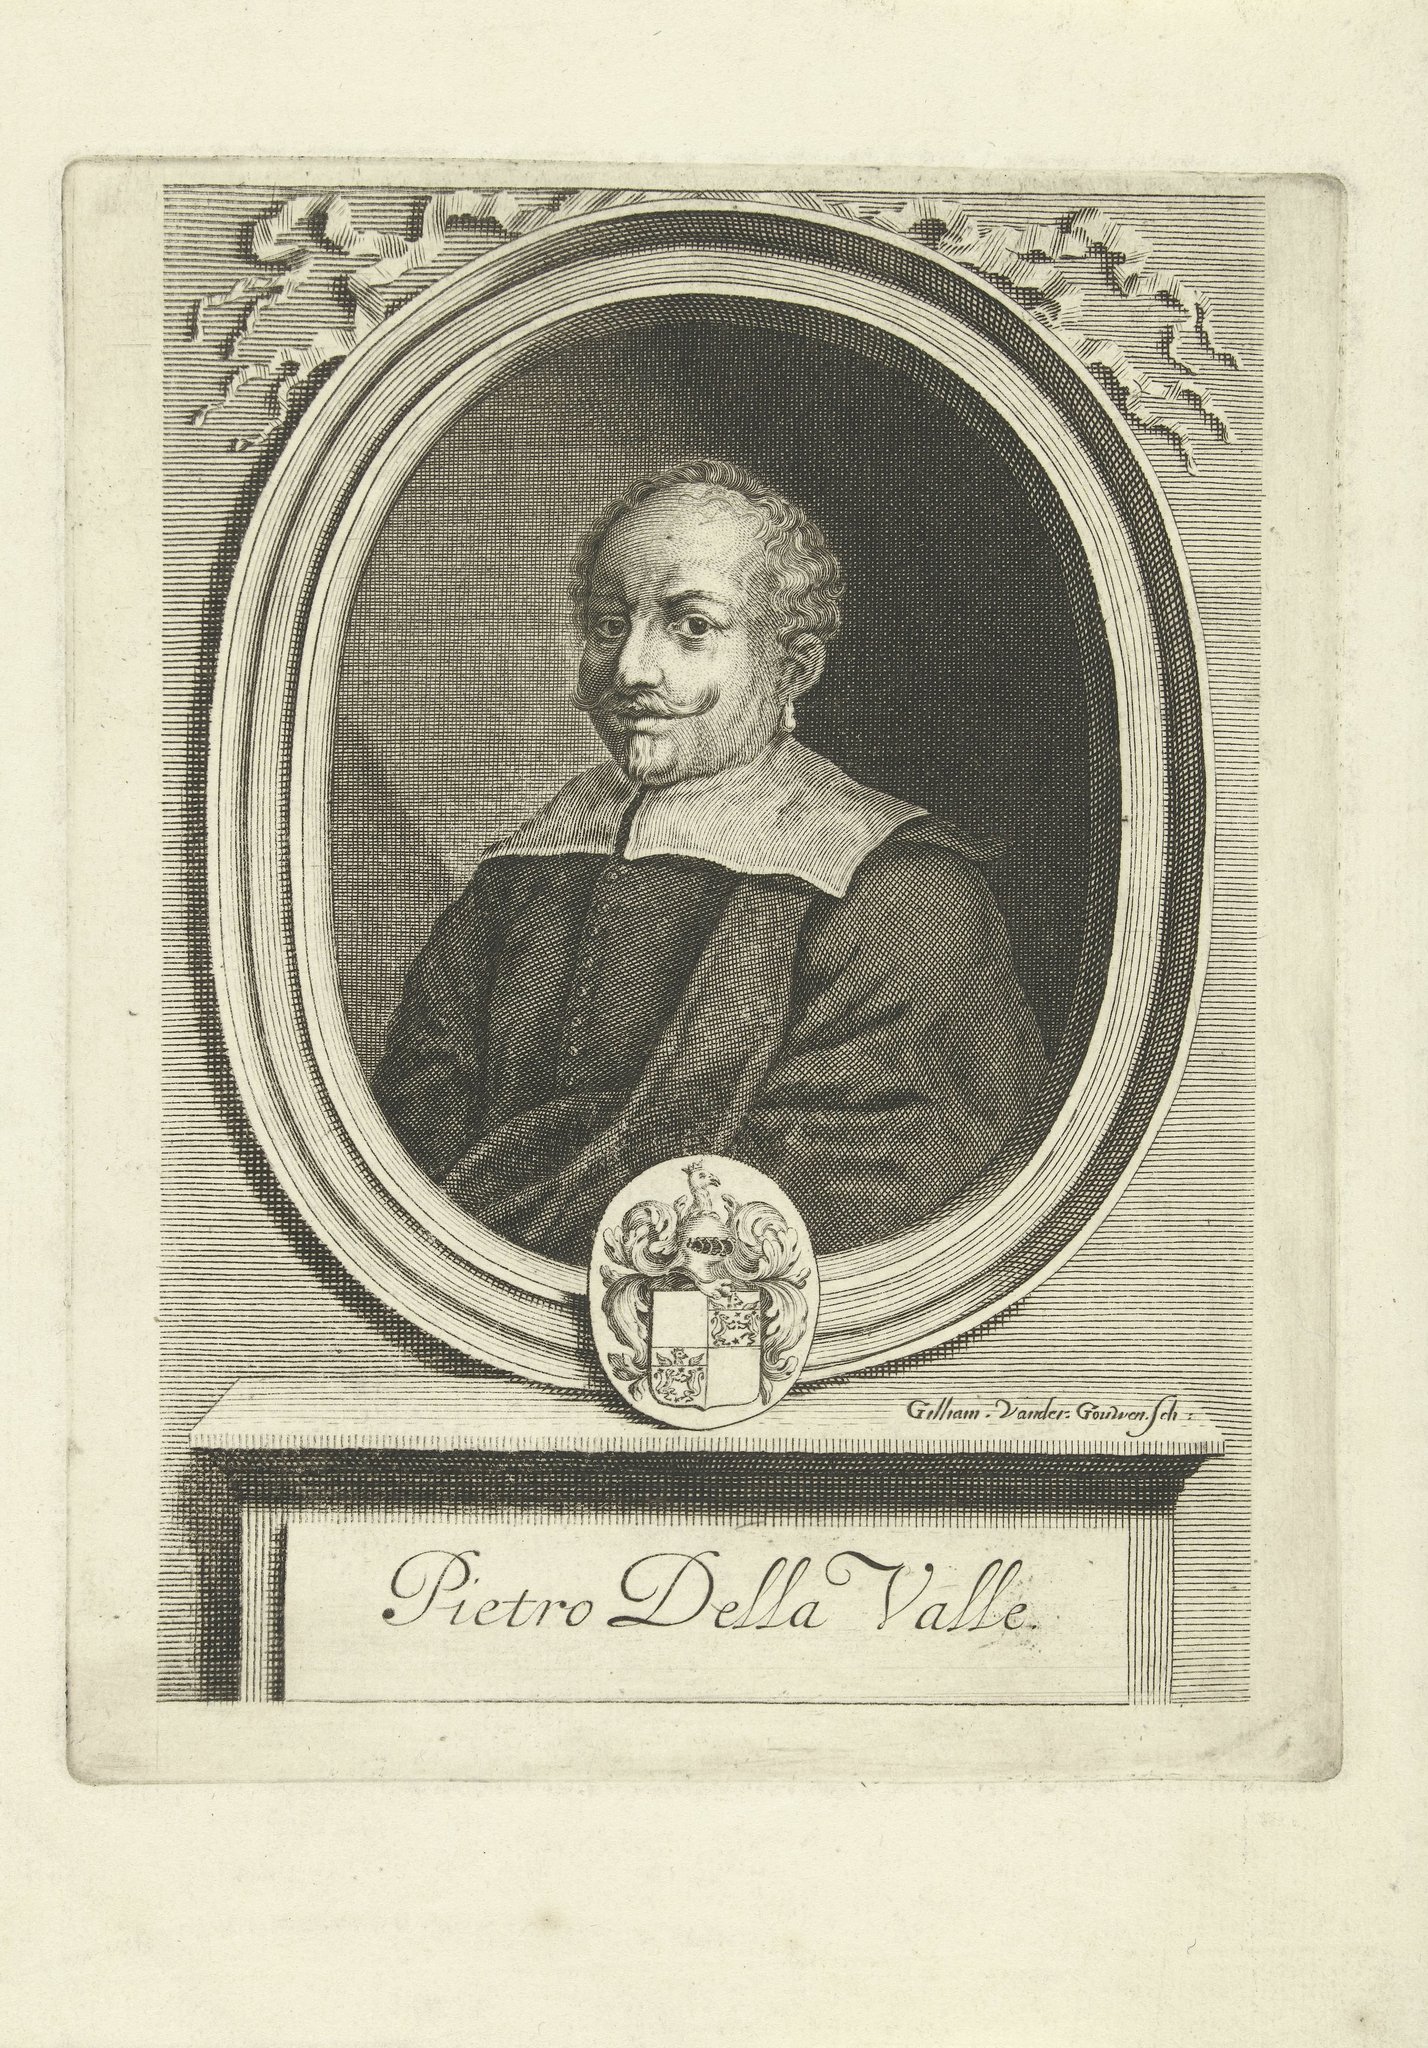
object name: print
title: Portret van Pietro della Valla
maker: gilliam van der gouwen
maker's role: print maker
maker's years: -1740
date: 1669-1740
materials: paper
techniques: engraving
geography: amsterdam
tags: rome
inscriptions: collector's mark: Lugt 2228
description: Portret in een ovale lijst van de Italiaan Pietro della Valla, een bekende reiziger van de Oriënt.